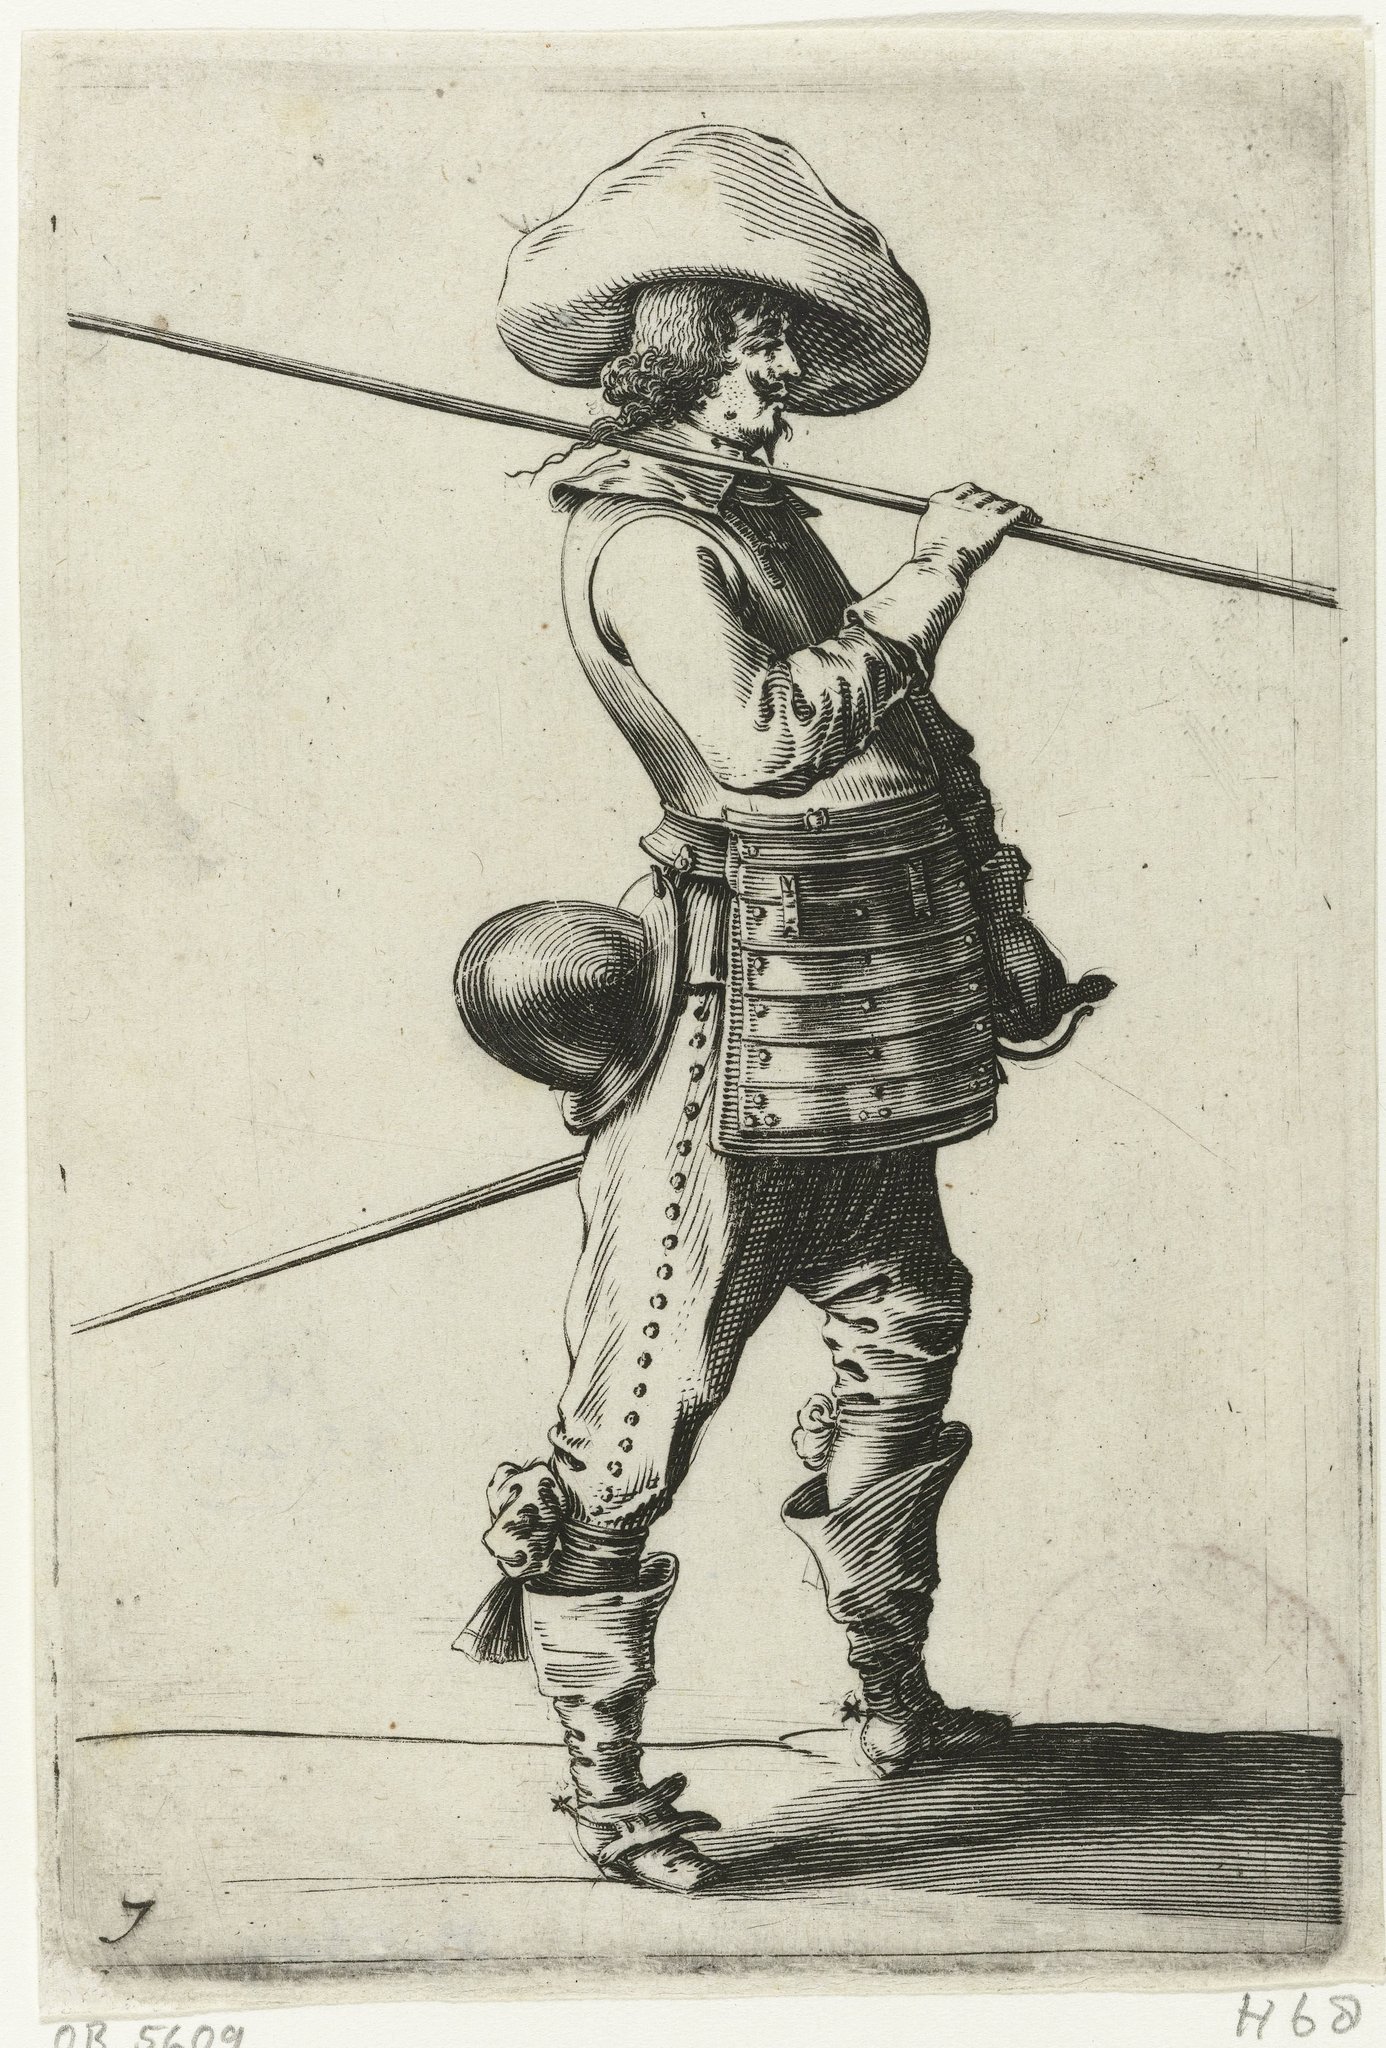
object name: costume print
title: Staande soldaat met borstkuras en speer over de schouder, en profil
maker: salomon savery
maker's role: print maker, publisher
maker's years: 1594-1683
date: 1630-1665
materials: paper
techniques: engraving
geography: amsterdam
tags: helved weapons, polearms (for striking, hacking, thrusting): lance, clothes, costume (+ men's clothes), the soldier; the soldier's life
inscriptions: collector's mark: Lugt 240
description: De prent maakt deel uit van een tiendelige serie met voorstellingen van gewapende officieren en soldaten, gekleed volgens de Nederlandse mode ca. 1625-1635.